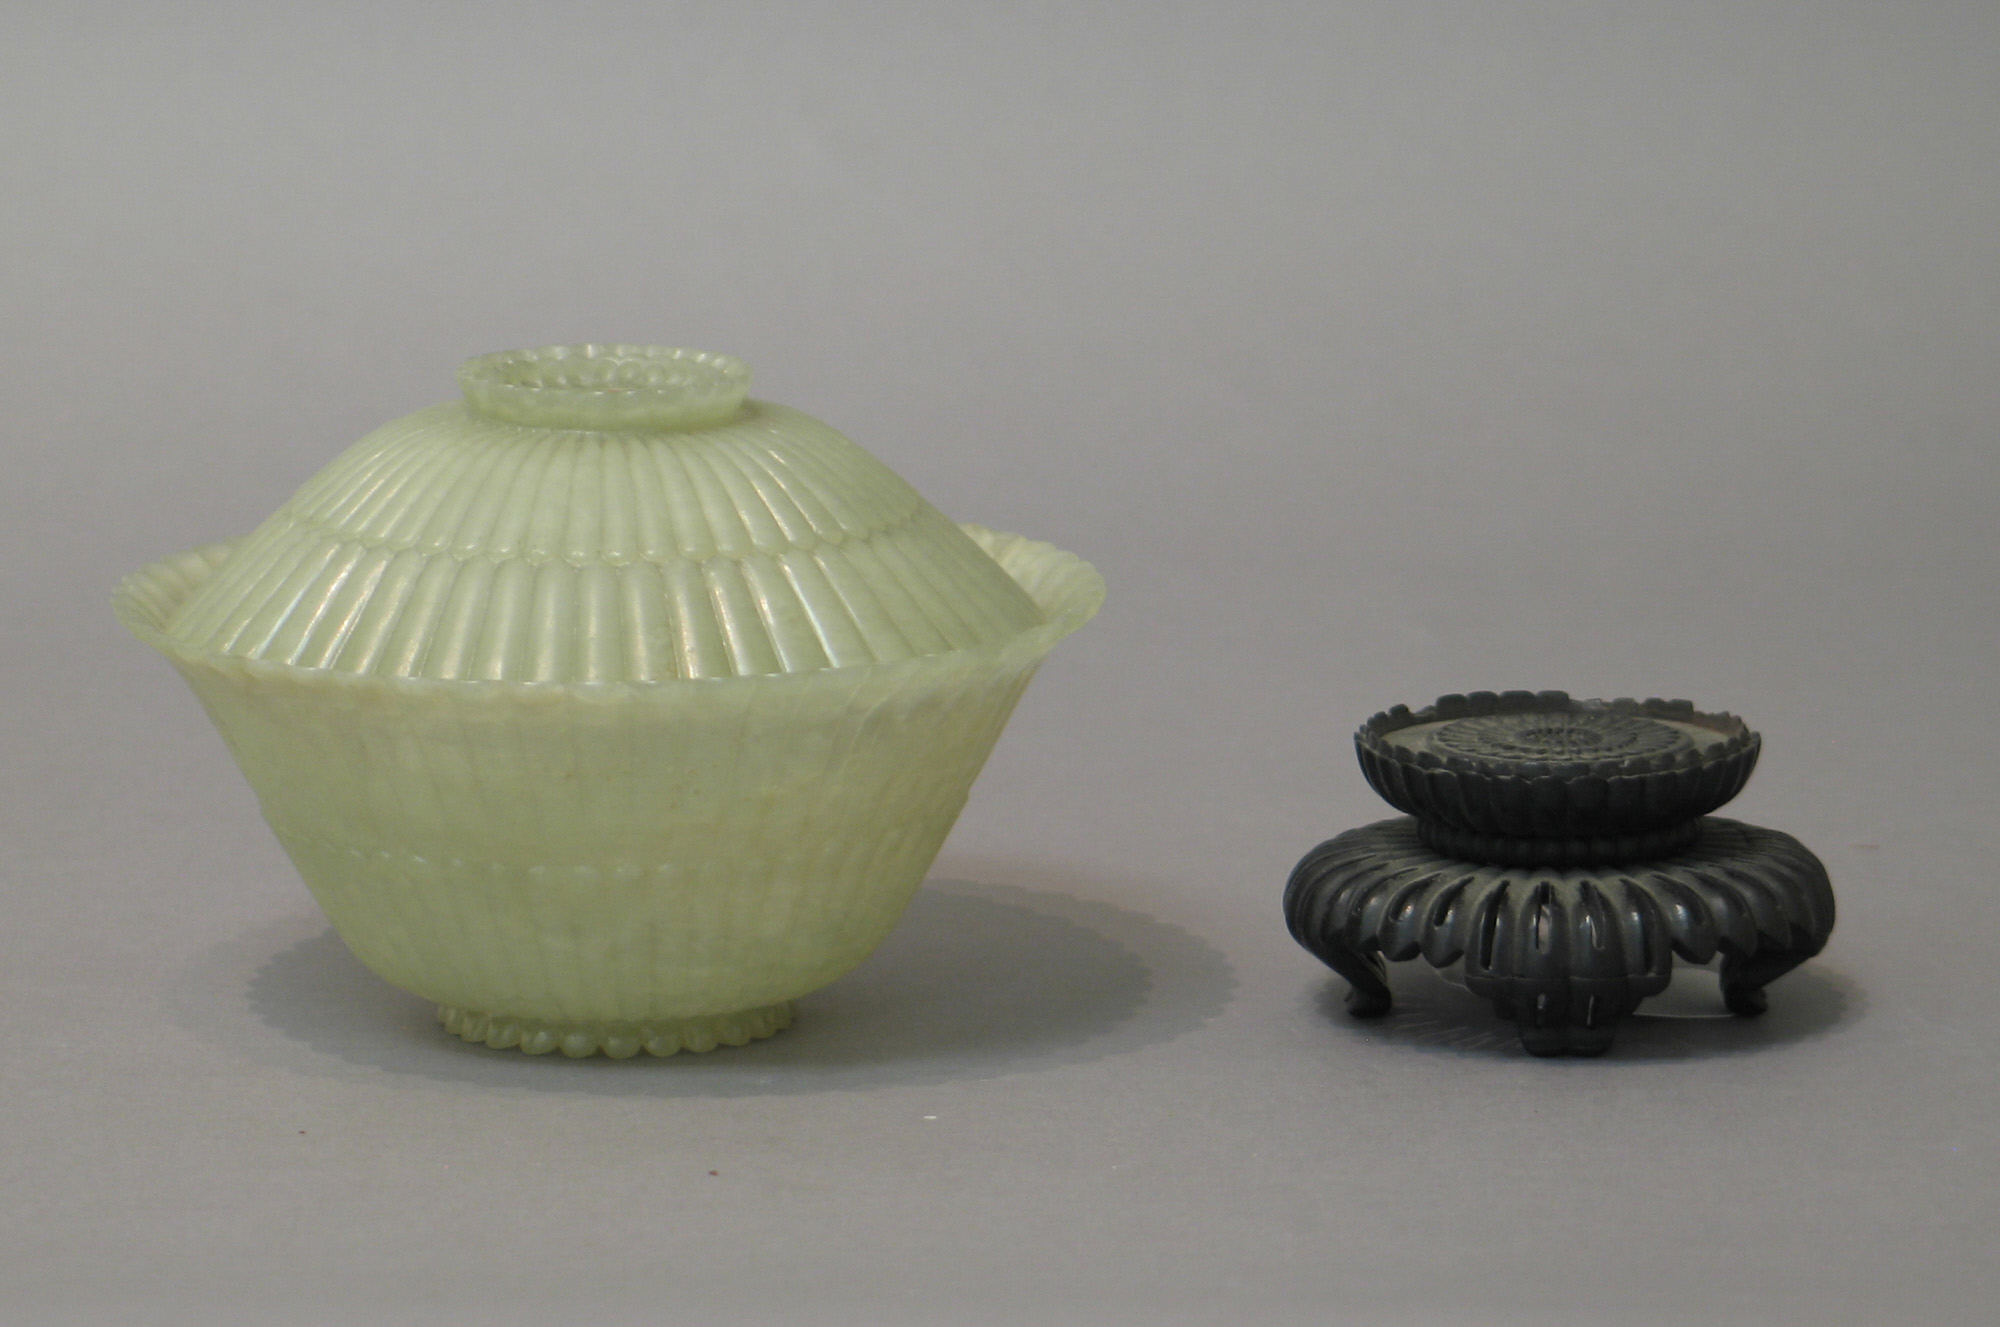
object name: cup with cover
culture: chinese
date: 1736-1795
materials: jade